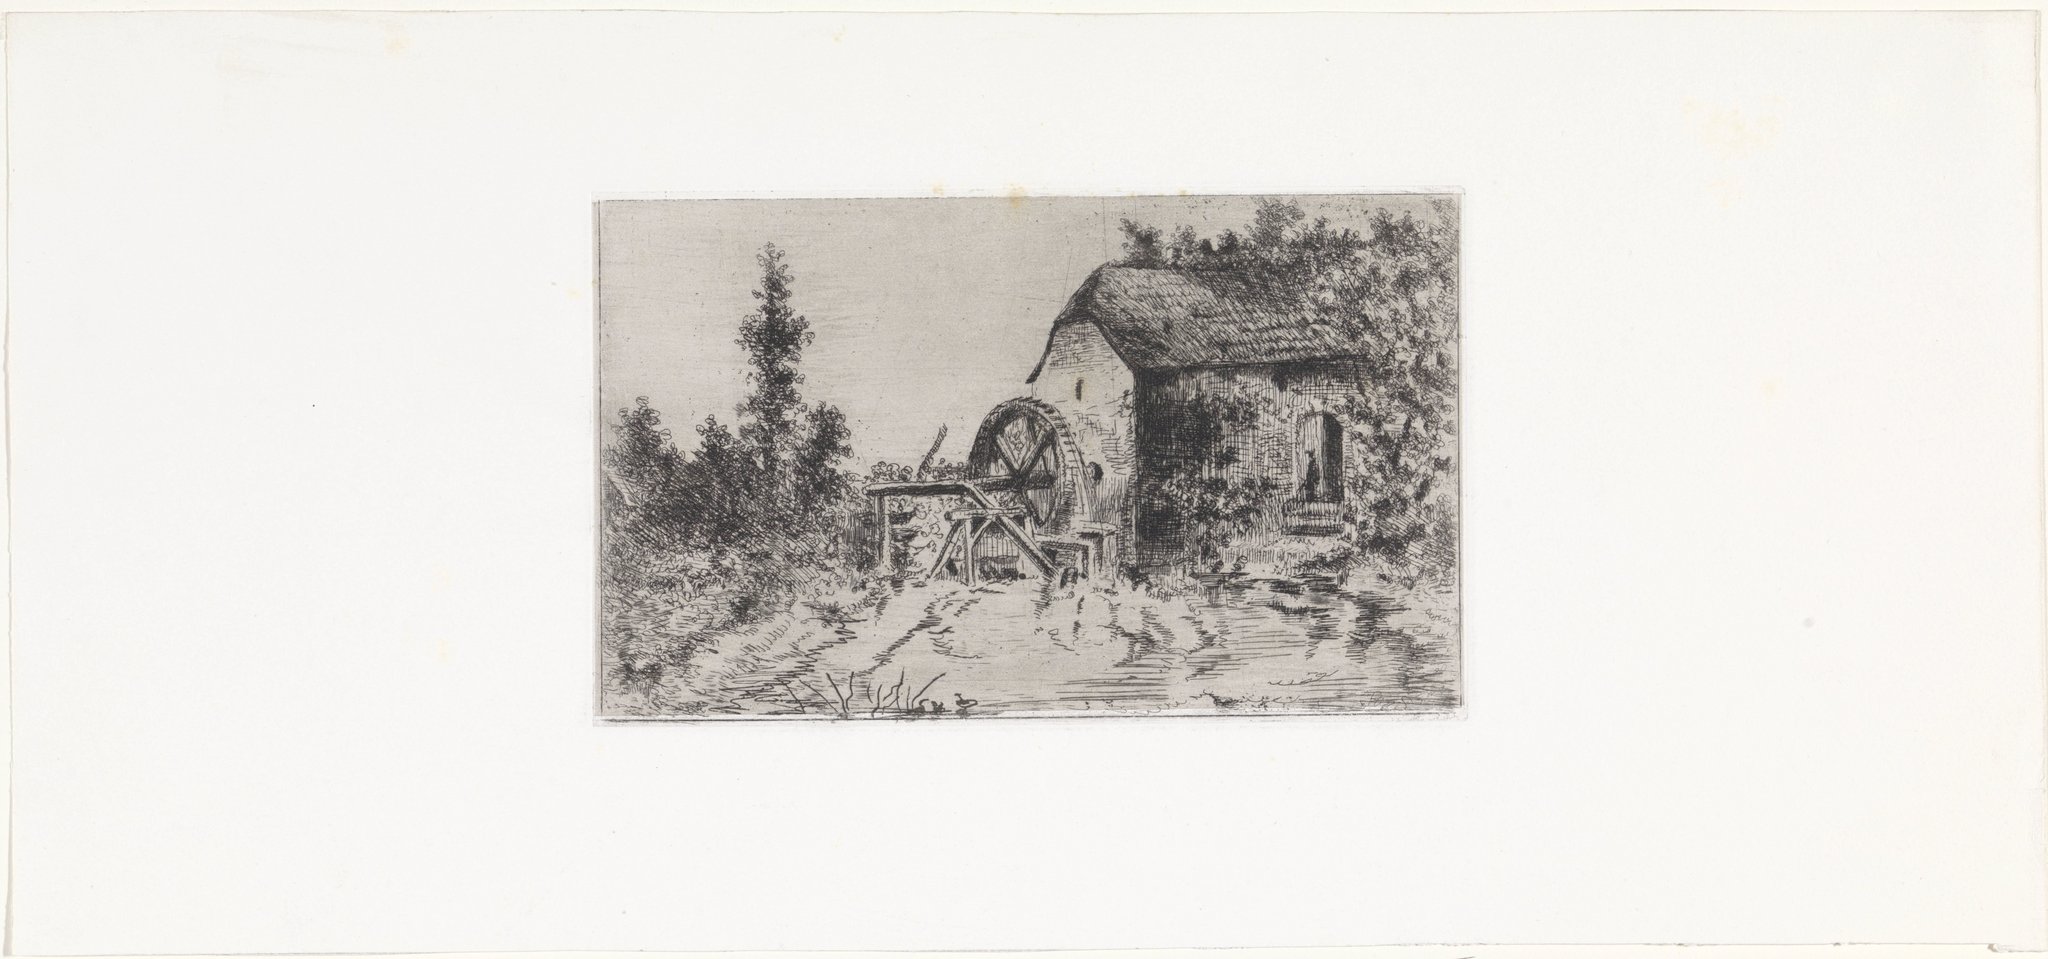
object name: print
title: Watermolen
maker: arnoud schaepkens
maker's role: print maker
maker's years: 1816-1904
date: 1855-1904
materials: paper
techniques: drypoint, etching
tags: watermill in landscape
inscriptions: collector's mark: Lugt 2228